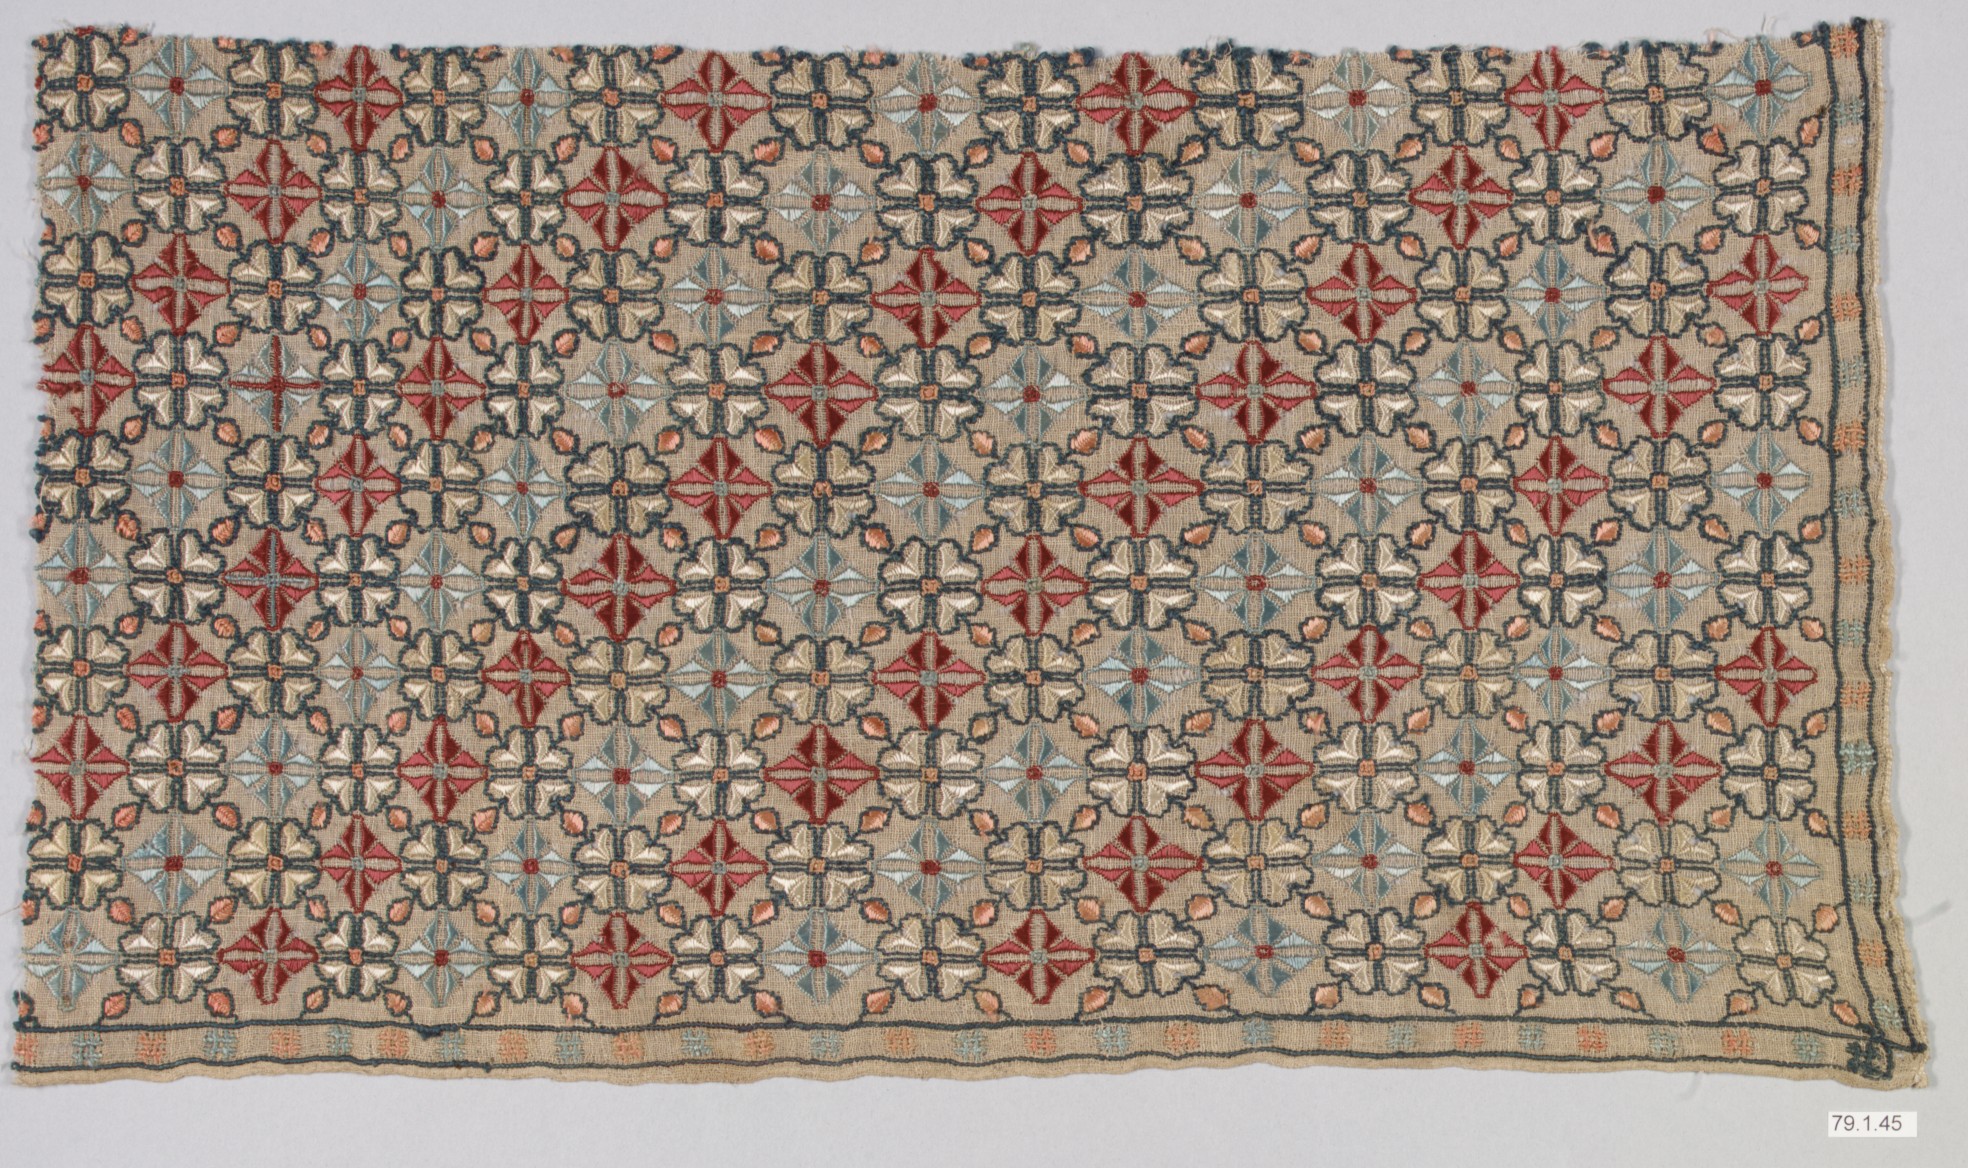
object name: textile fragment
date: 1801-1833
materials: linen, silk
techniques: embroidery, weave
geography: greece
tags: flowers